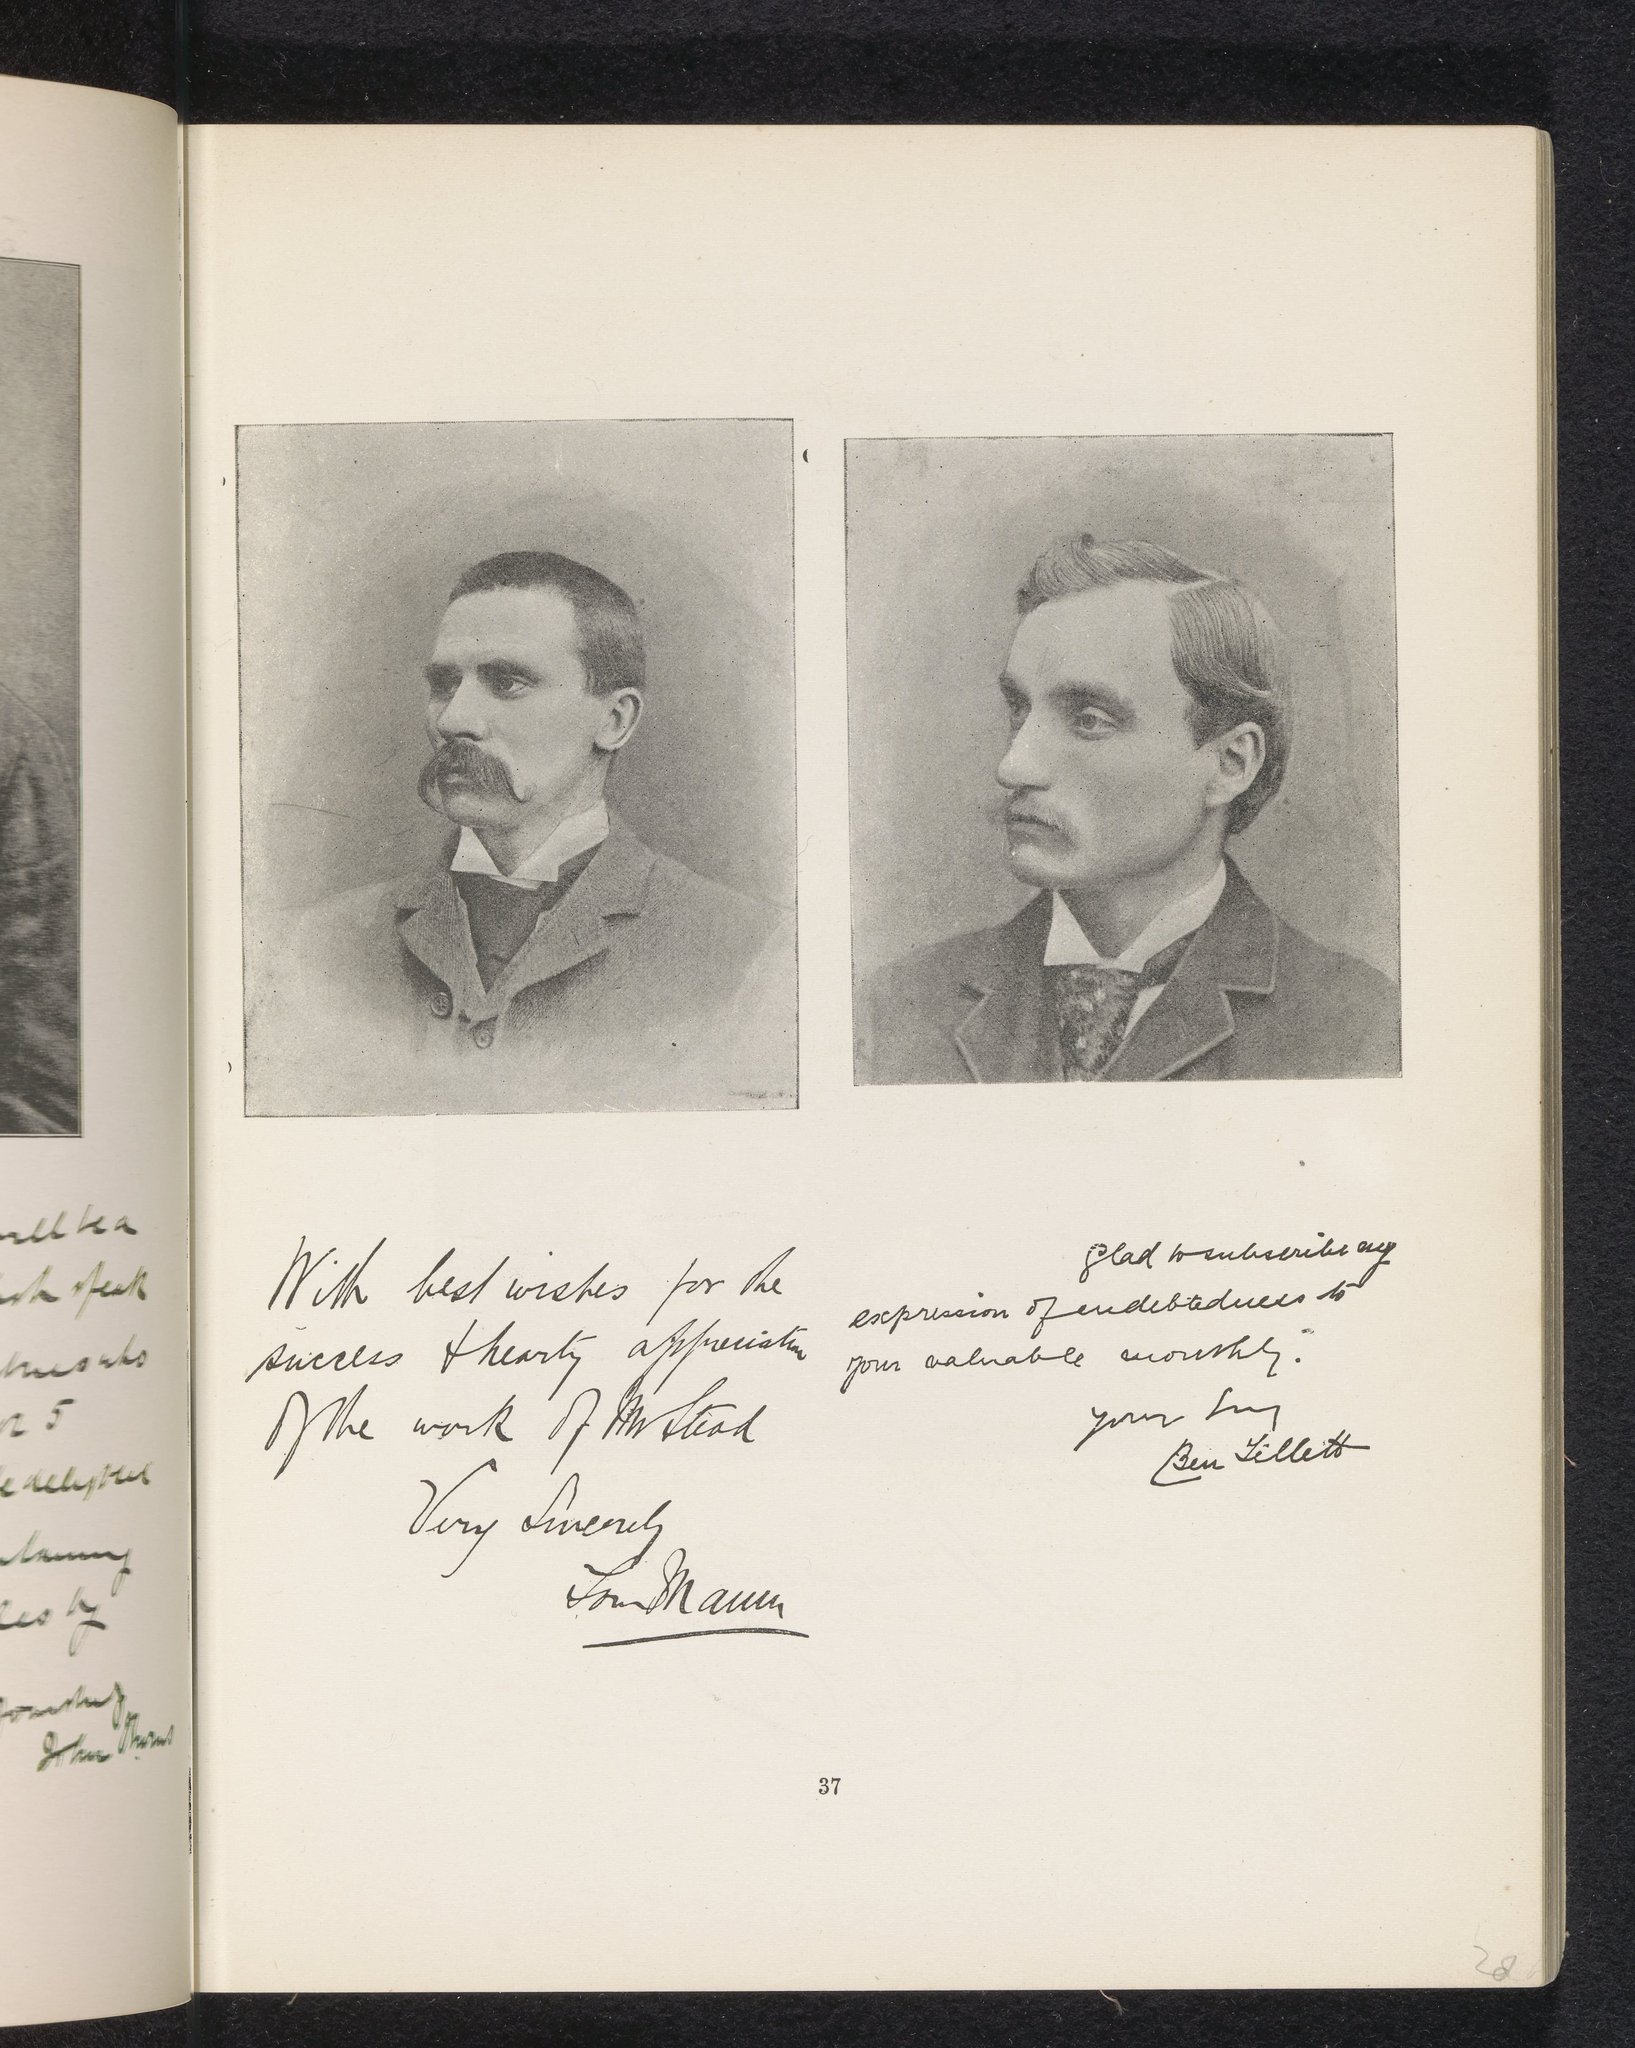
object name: photomechanical print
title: Twee portretten van Ben Tillett en Tom Mann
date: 1881-1891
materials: paper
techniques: autotype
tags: politician, e.g. party leader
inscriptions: inscription